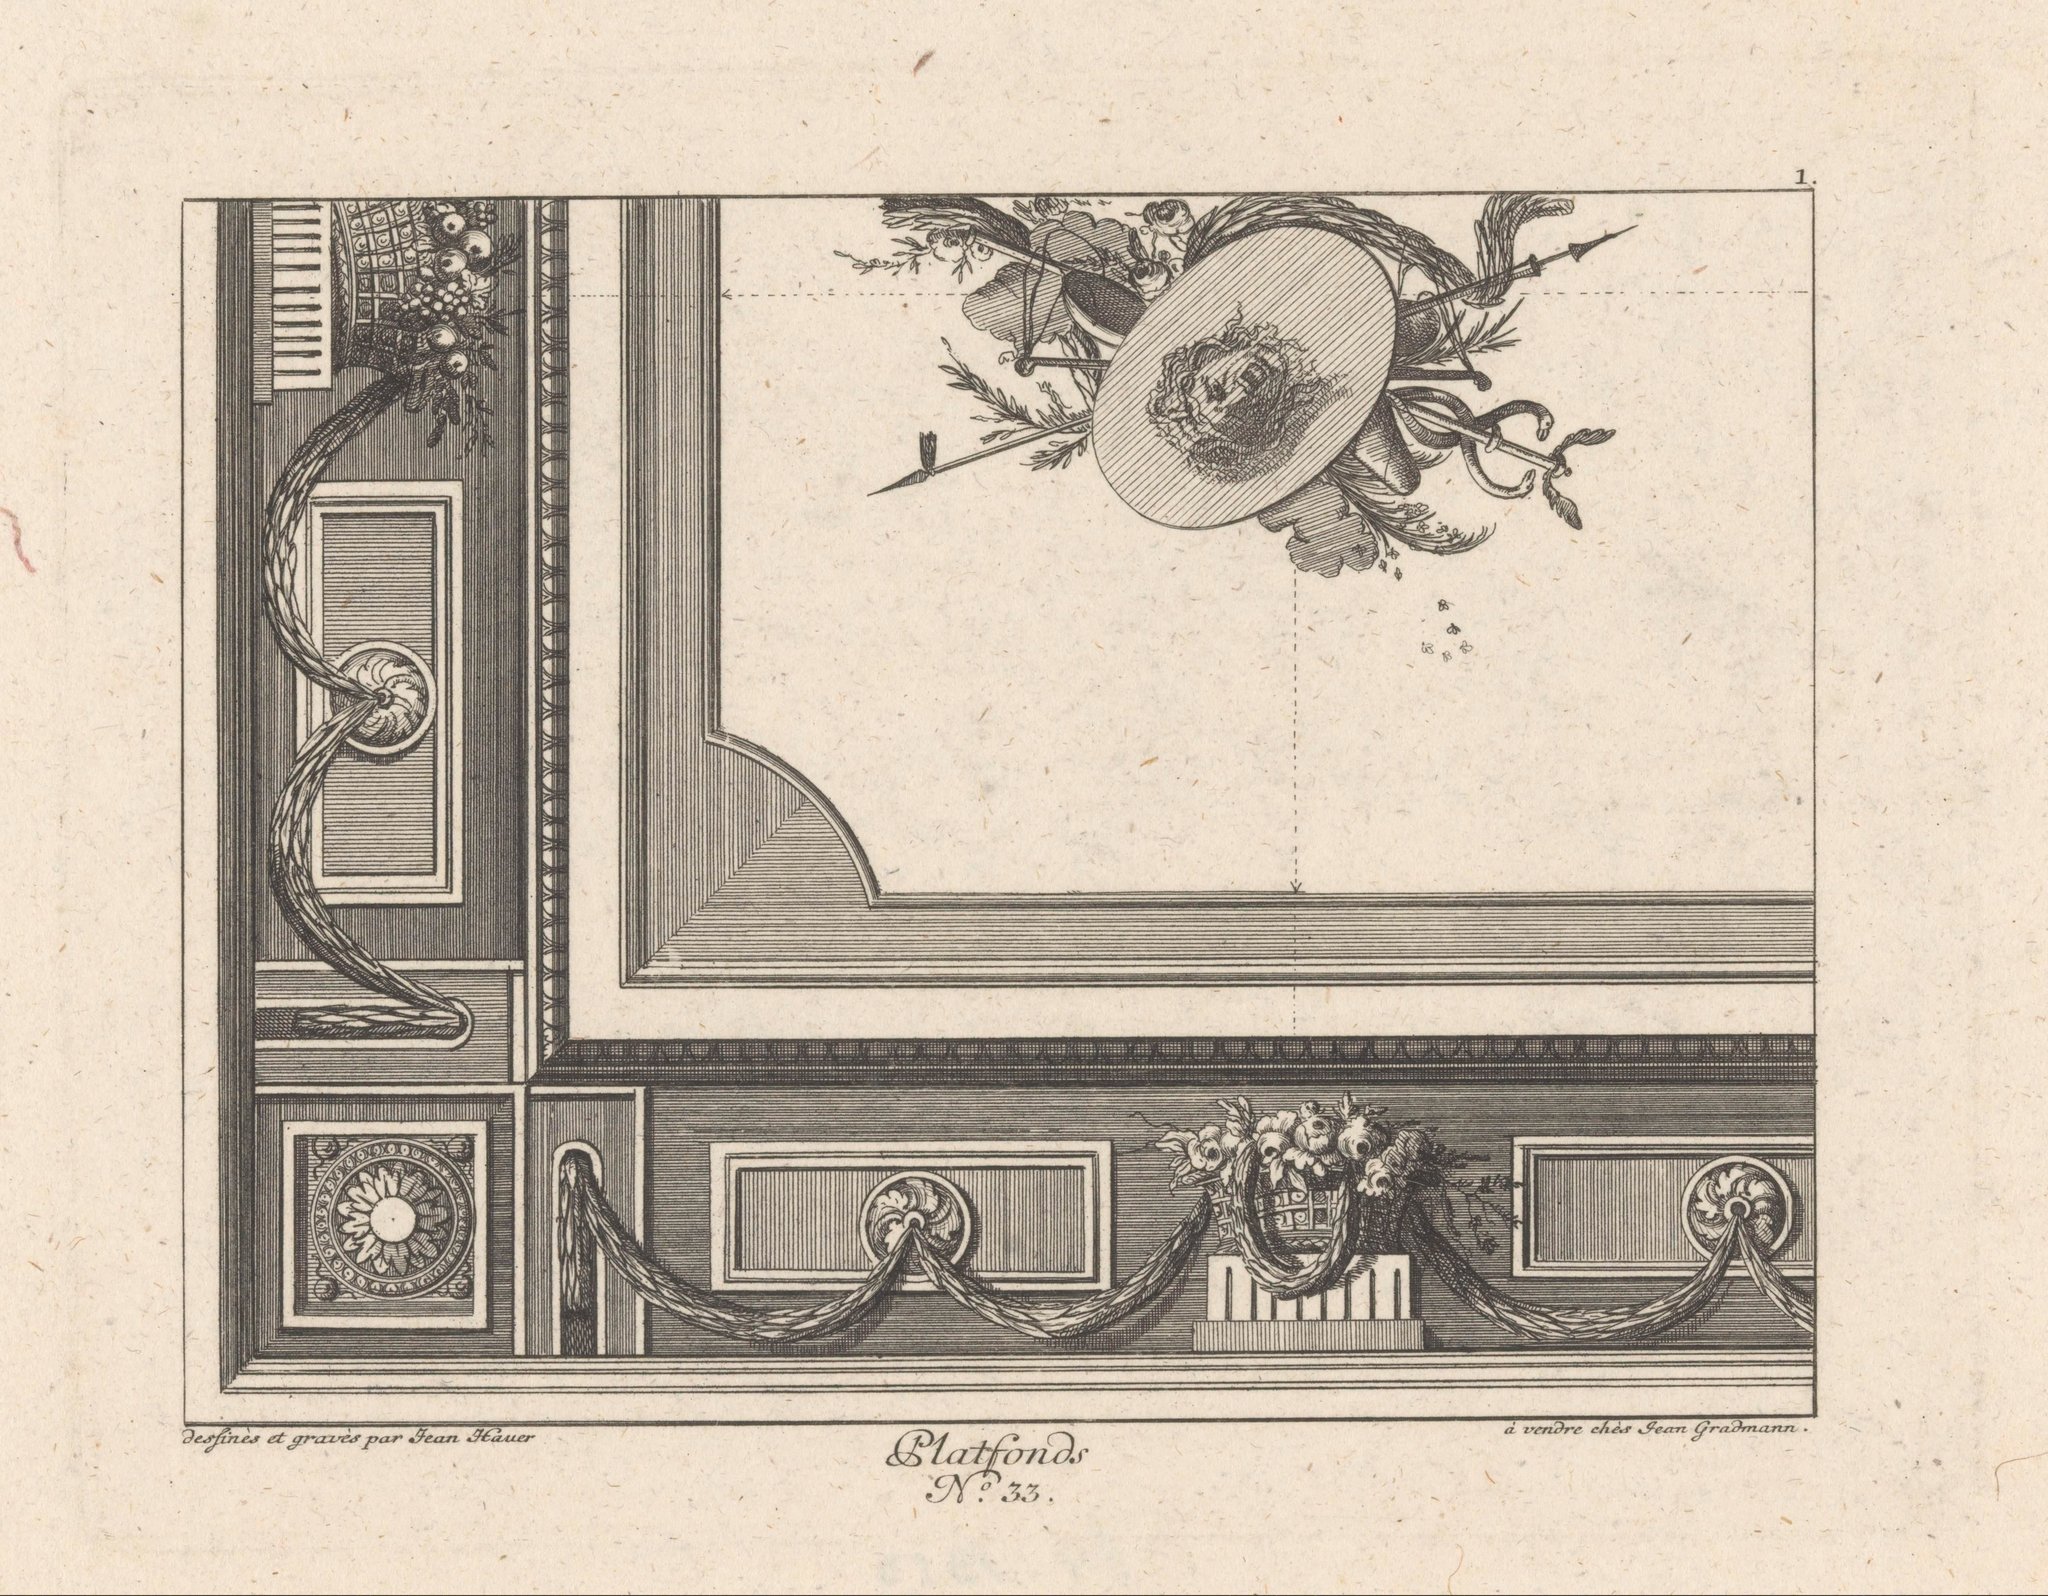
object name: print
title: Plafond met Medusakop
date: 1758-1820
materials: paper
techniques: engraving, etching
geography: ravensburg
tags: (decorated) ceiling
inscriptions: collector's mark: Lugt 2760, collector's mark: Lugt 2228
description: Ontwerp voor een plafond met ornamenten, guirlandes en bloemenmanden in de omlijsting. In het midden een schild met Medusakop, Mercuriusstaf en lansen. Uitgeversnummer 33.